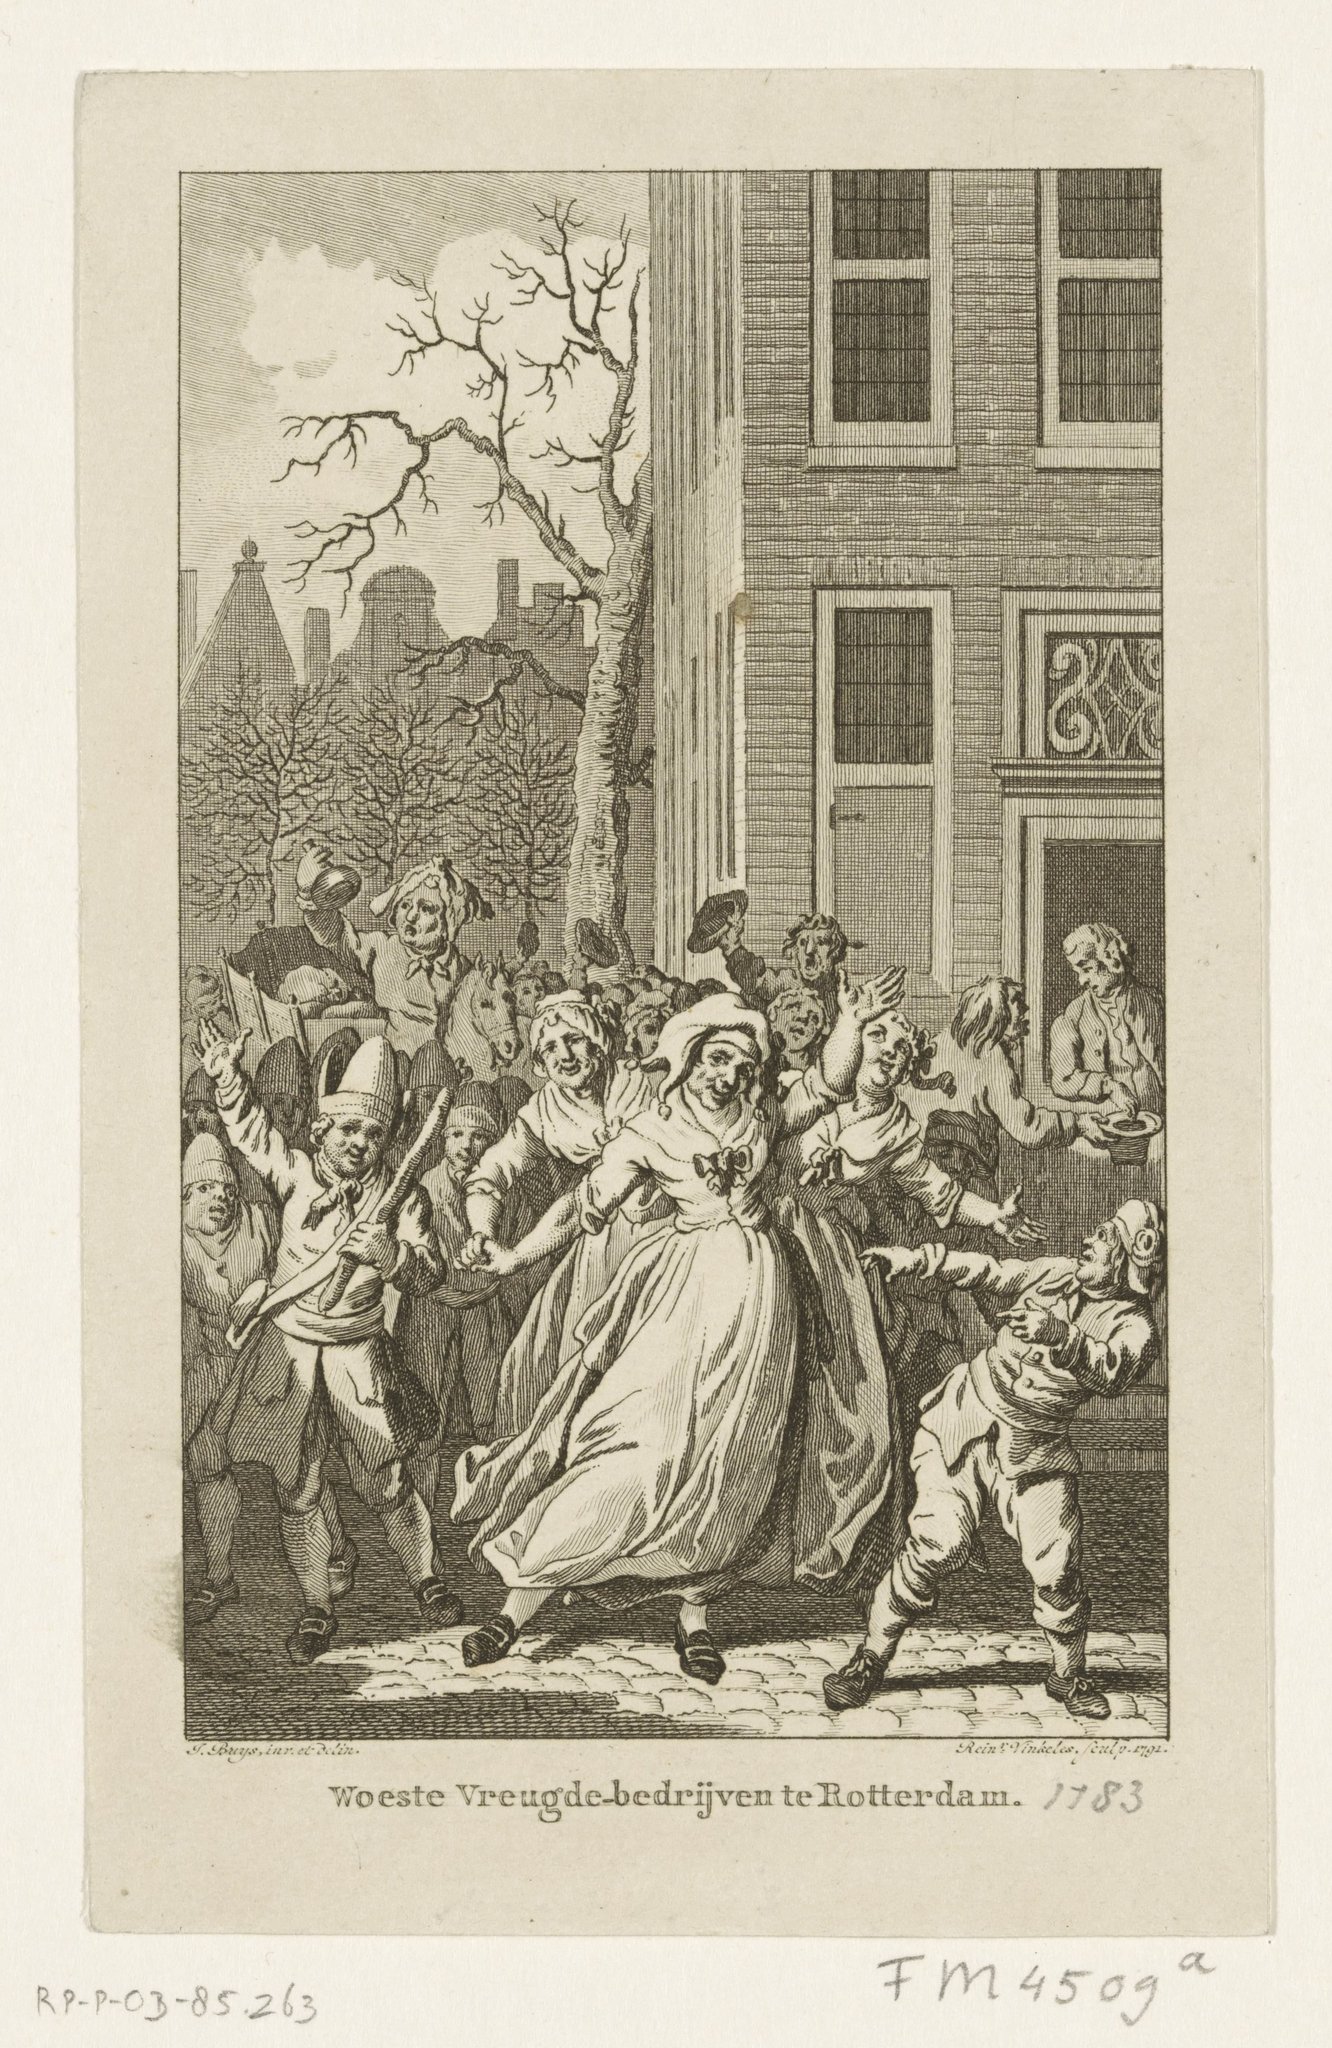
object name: print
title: Woeste Vreugde-bedrijven te Rotterdam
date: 1791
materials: paper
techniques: engraving, etching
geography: northern netherlands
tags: the hague, william v (prince of orange), public festivities on the occasion of royal events, rotterdam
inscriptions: collector's mark: Lugt 2228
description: Gebruikt als illustratie: P.A. Loosjes. Vaderlandsche historie, vervattende de geschiedenissen, der Vereenigde Nederlanden (...). Ten onmiddelyken vervolge van Wagenaar's Vaderlandsche historie, dl. 6. Amsterdam: Johannes. Allart, dl. 7, 1791.